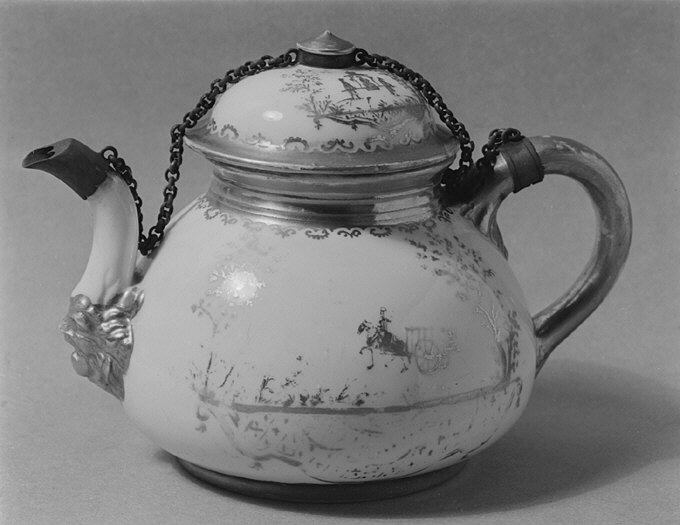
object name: teapot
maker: meissen manufactory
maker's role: manufactory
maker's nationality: german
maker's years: 1710-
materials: hard paste porcelain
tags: carriages